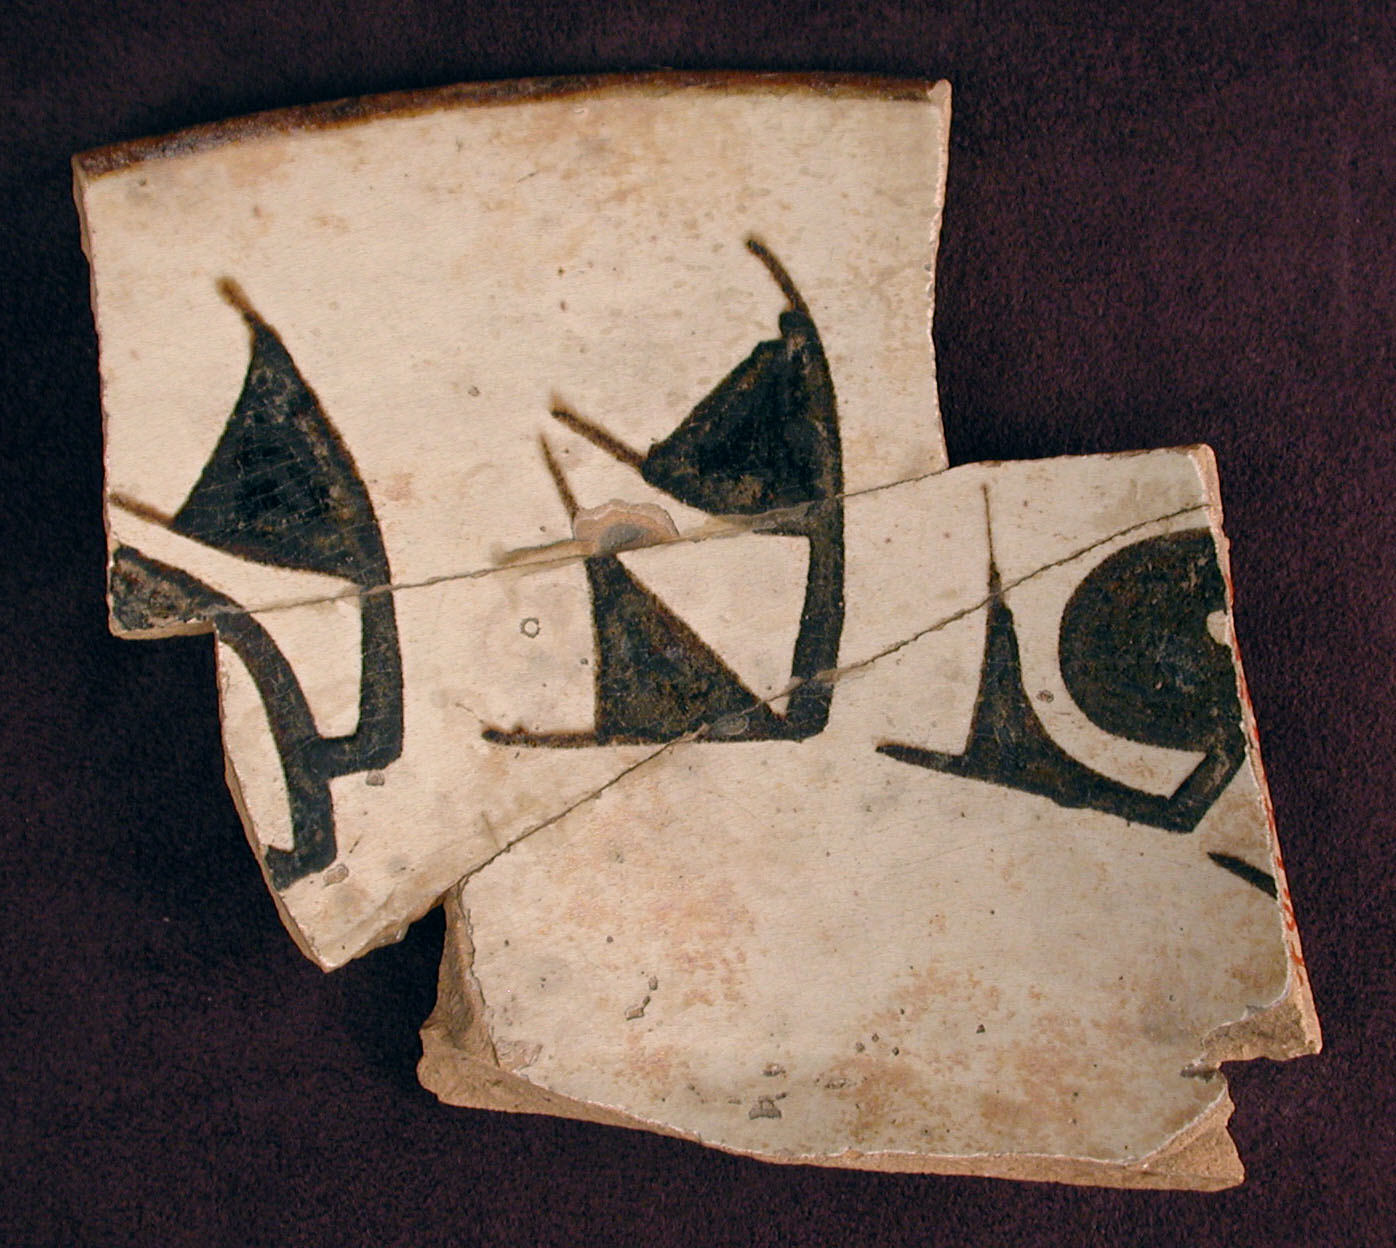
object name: fragment of a bowl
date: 801-1000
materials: earthenware, glaze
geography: iran